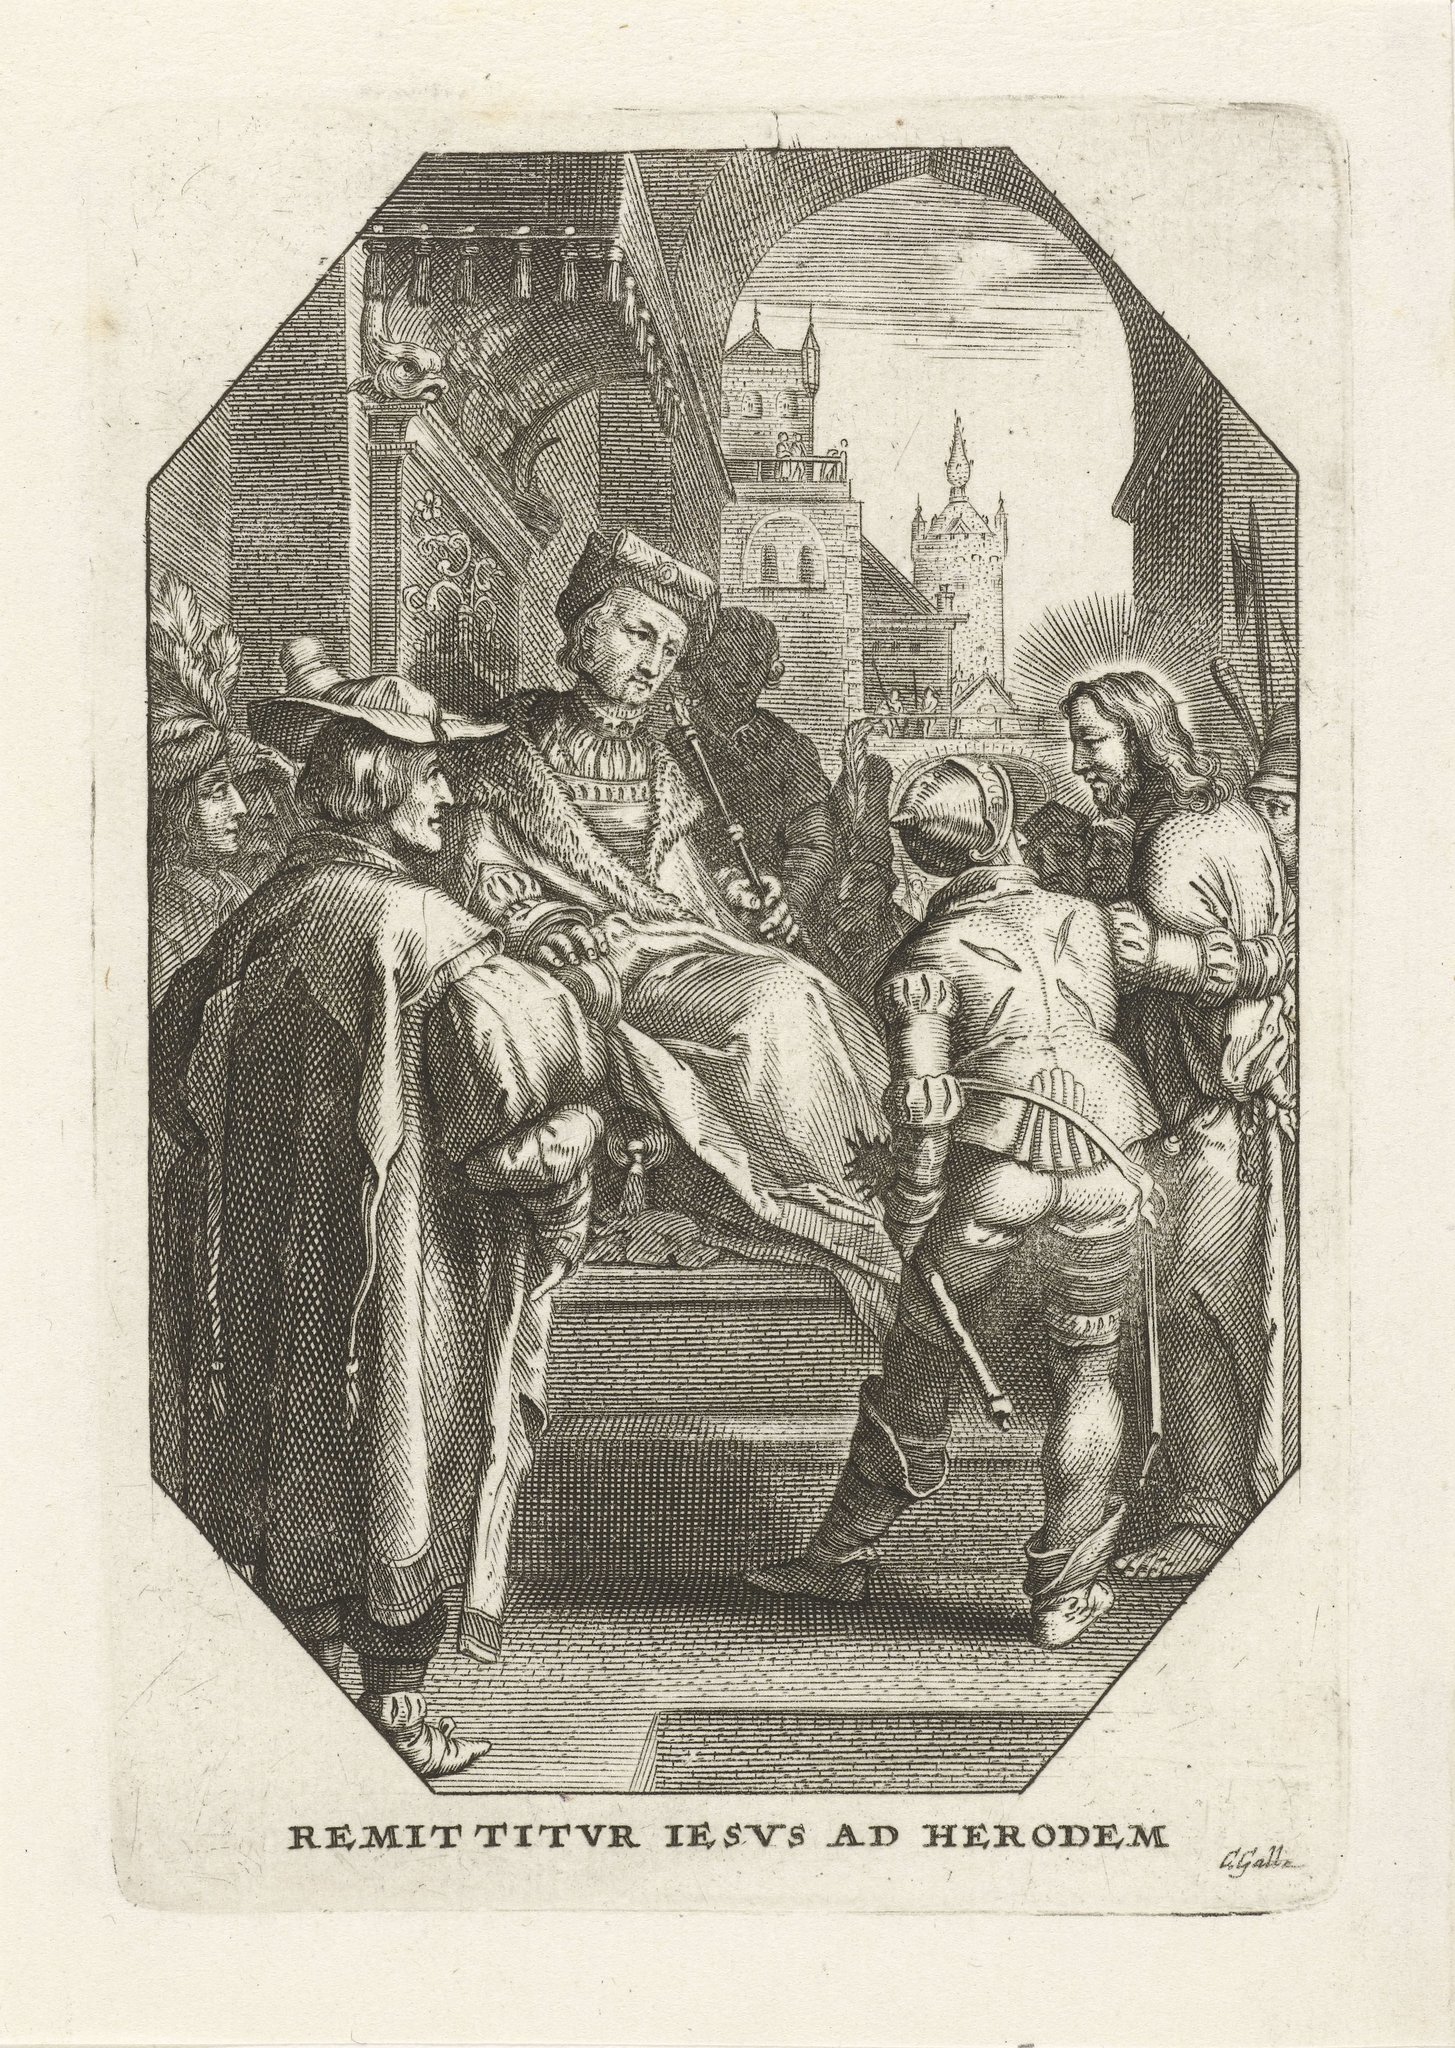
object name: print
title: Remit titvr Iesvs ad Herondem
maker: cornelis galle (i)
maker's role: print maker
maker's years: 1576-1650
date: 1586-1650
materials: paper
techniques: engraving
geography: southern netherlands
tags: christ before king herod; sometimes a gorgeous robe is brought (luke 23:8-11)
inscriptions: collector's mark: Lugt 2228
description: Christus wordt door twee soldaten voorgeleidt voor koning Herodes. Zesde prent uit een serie van 13, met voorstellingen uit het lijdensverhaal van Christus.